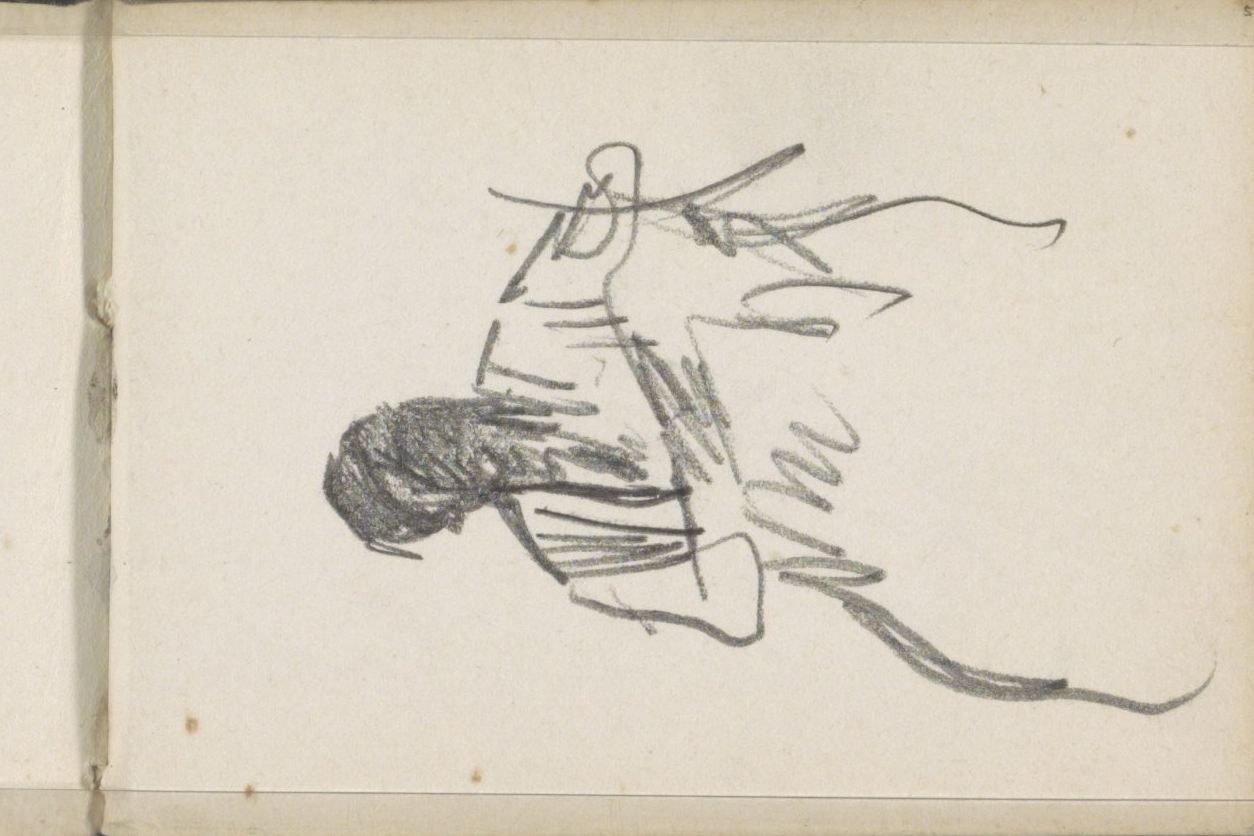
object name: sketchbook leaf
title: Algerijn, ten halven lijve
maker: marius bauer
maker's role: draughtsman, print maker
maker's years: 1867-1932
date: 1922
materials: paper, pencil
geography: biskra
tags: africans, adult man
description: Pagina 5 uit een schetsboek met 32 bladen.